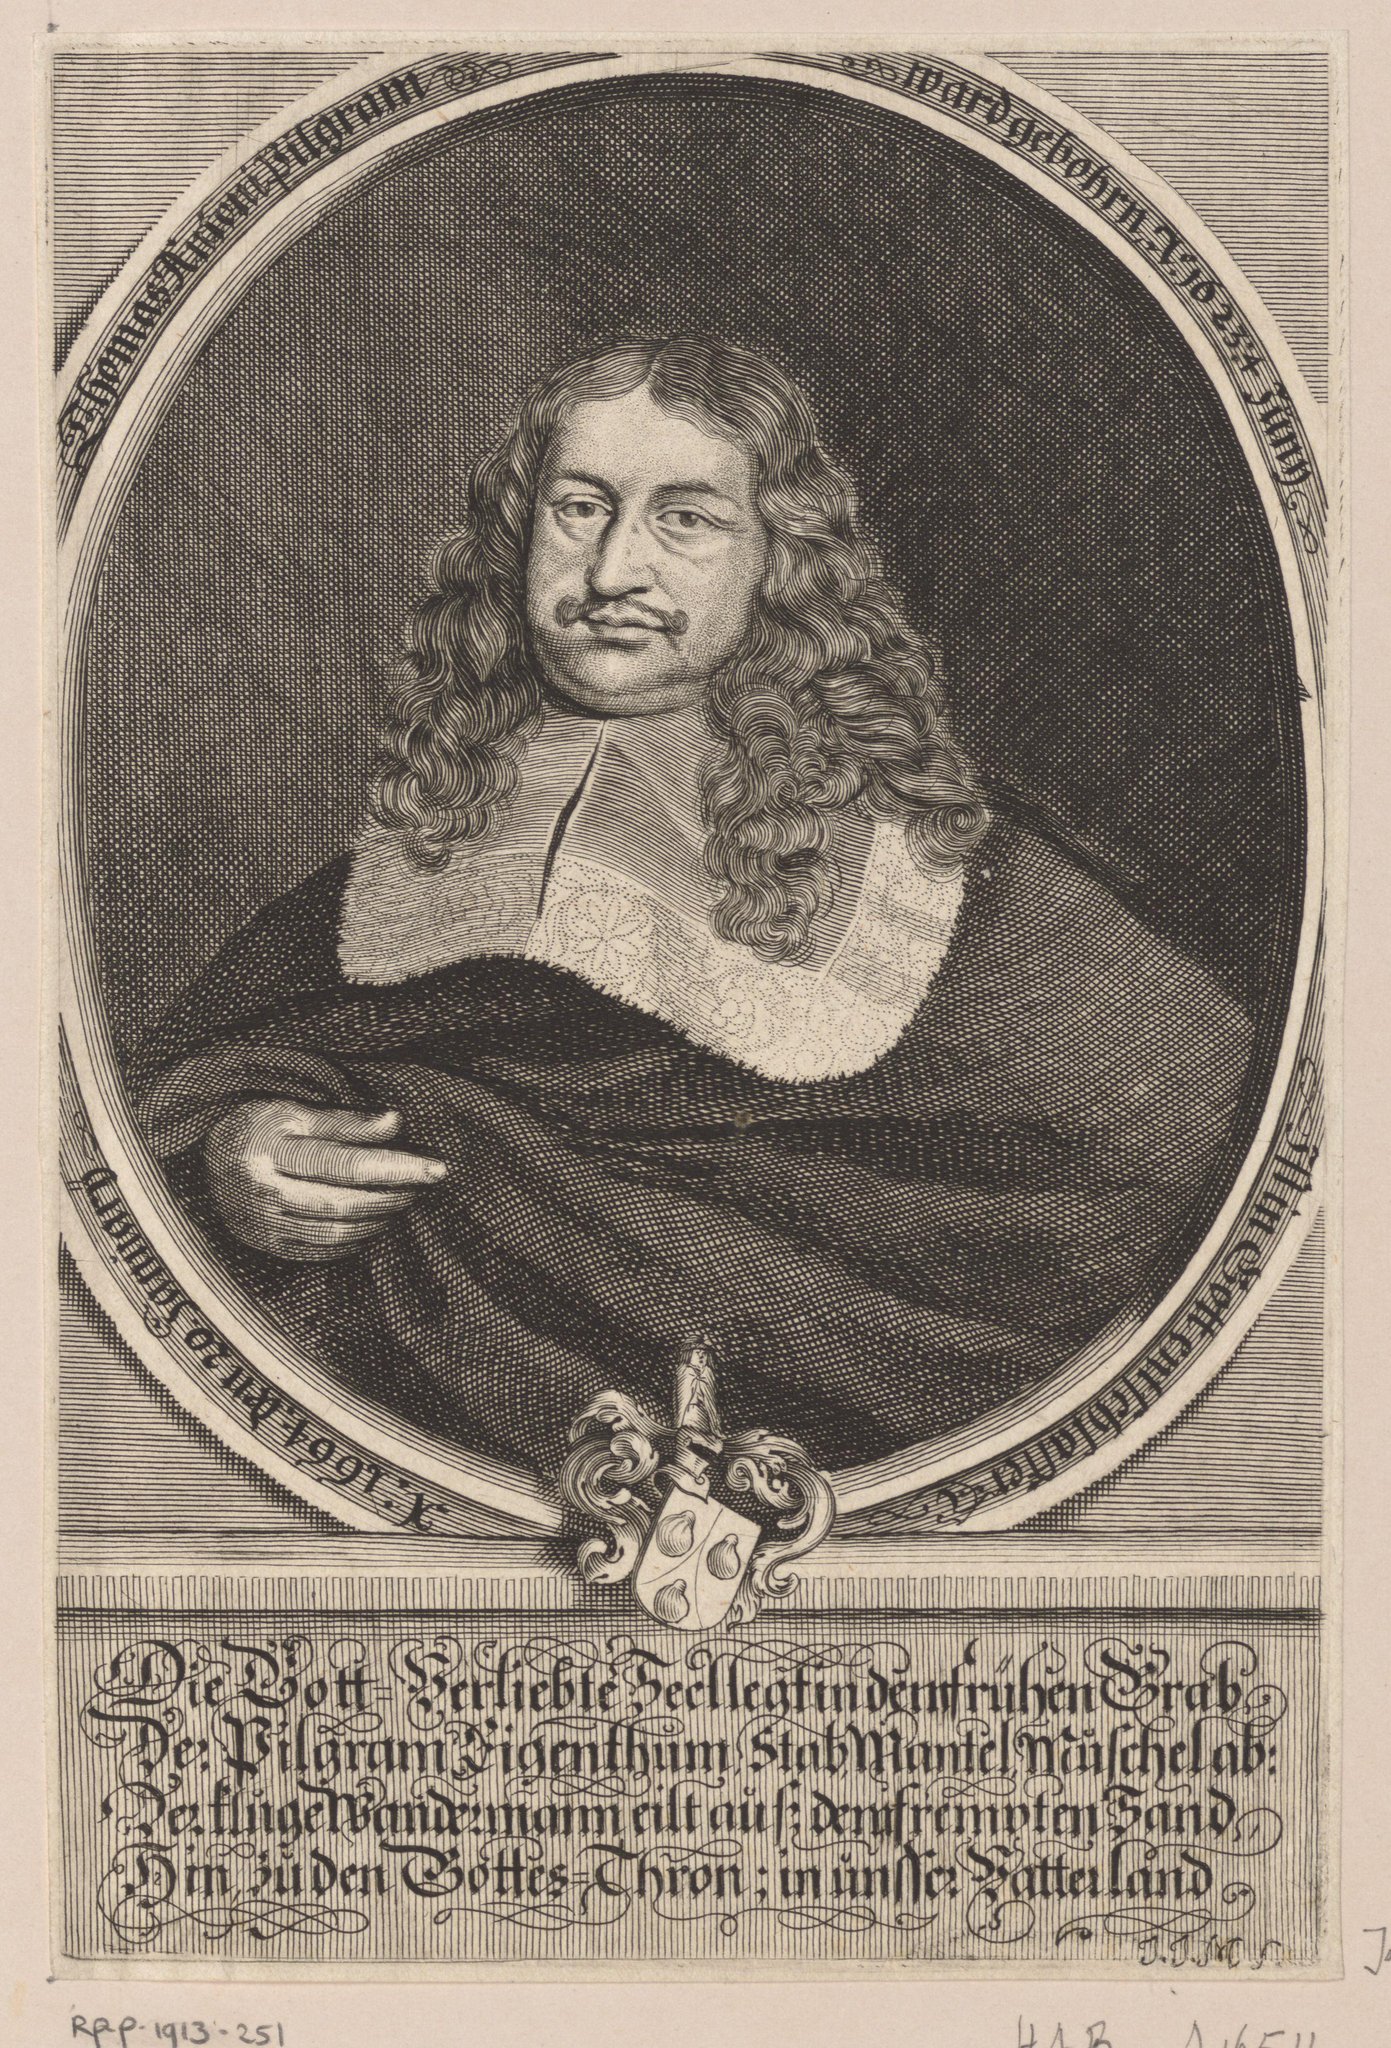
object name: print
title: Portret van Thomas Anton Pilgram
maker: johann jakob metzger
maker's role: print maker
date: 1664-1675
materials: paper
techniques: engraving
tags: adult man, historical persons, armorial bearing, heraldry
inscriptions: collector's mark: Lugt 2228